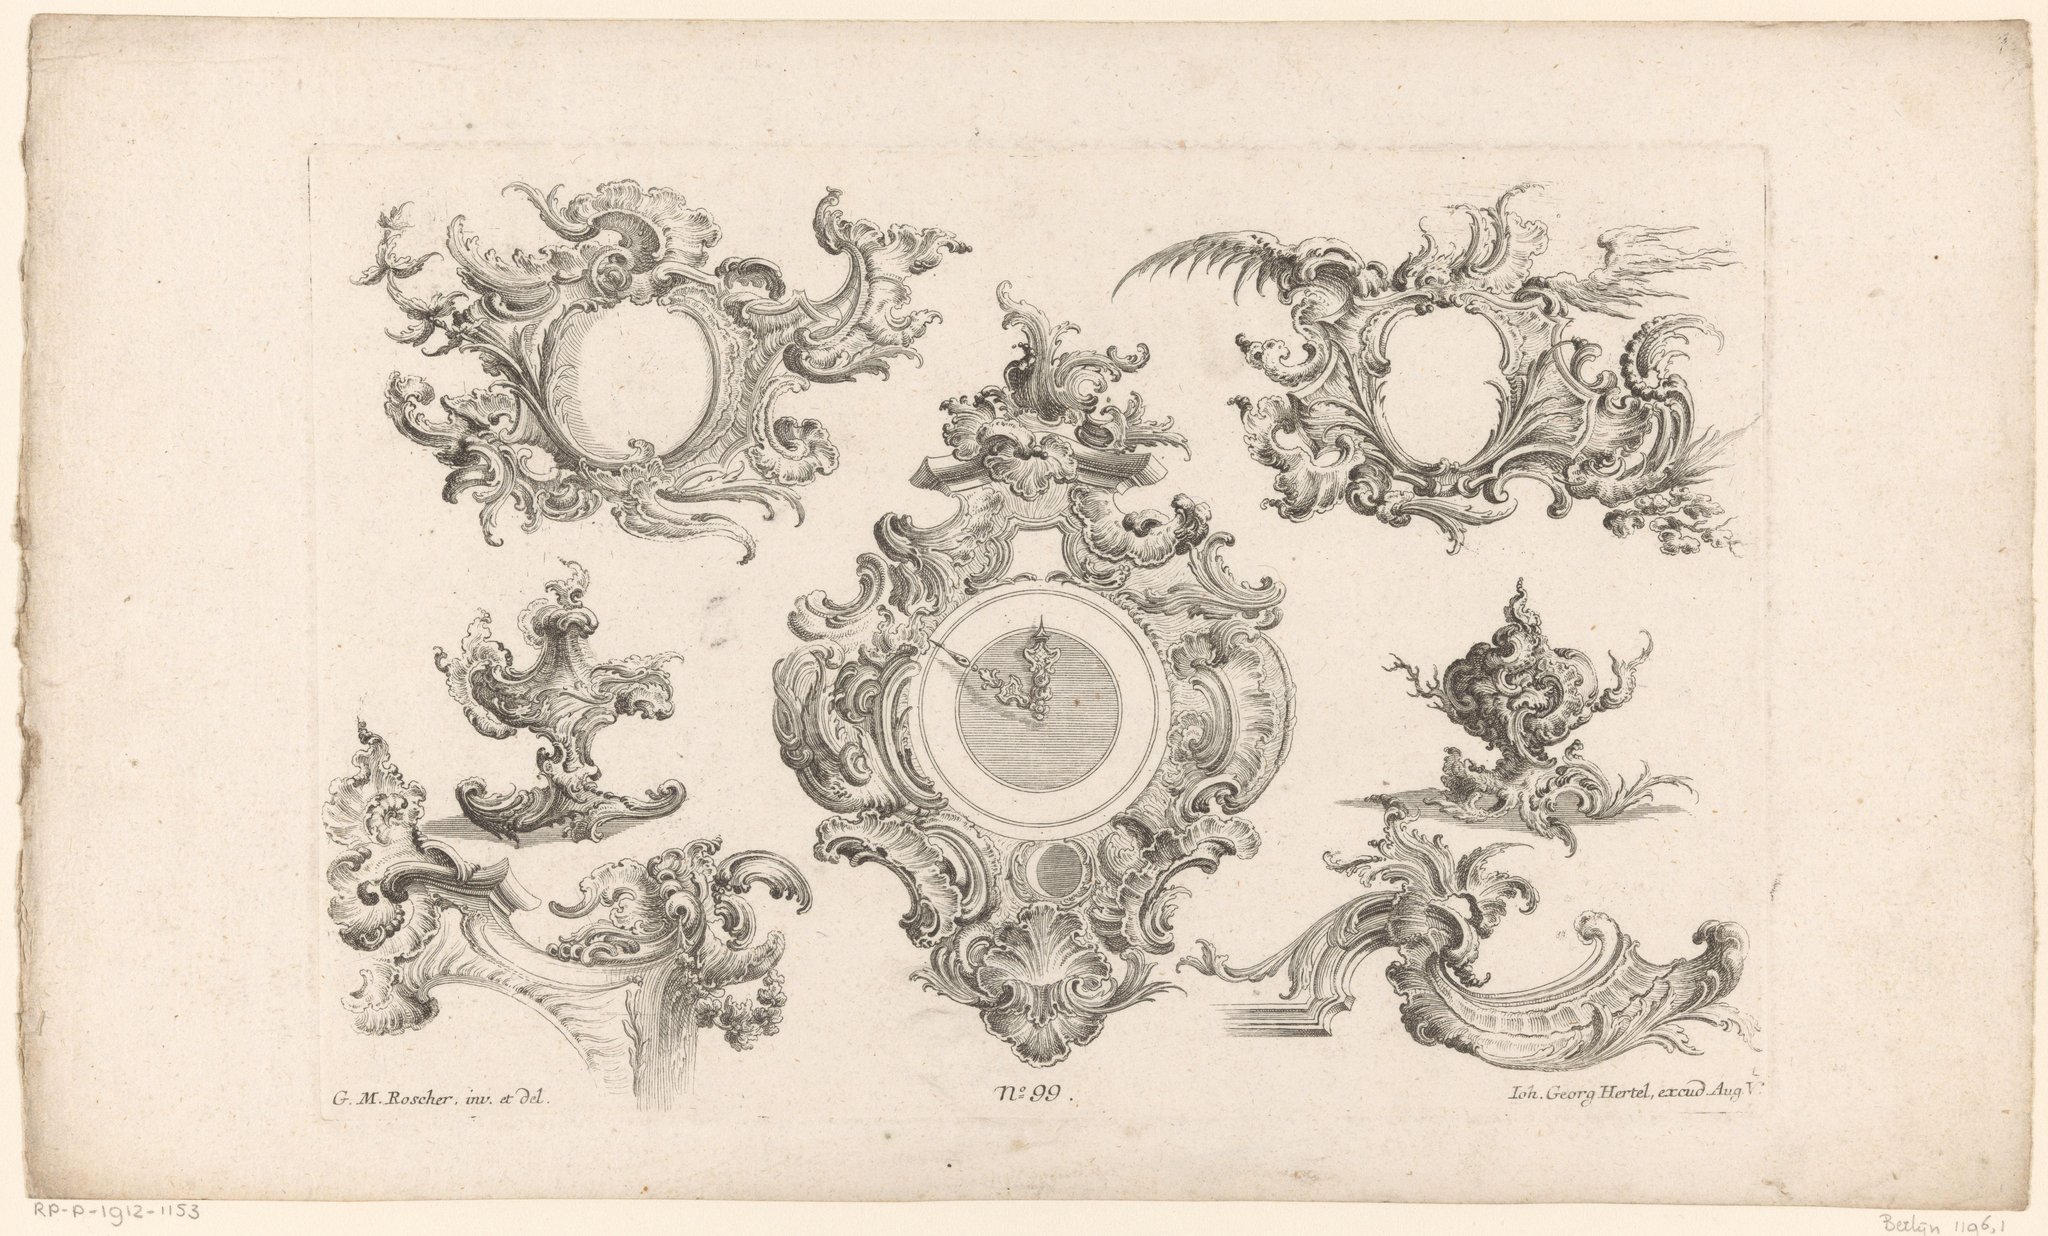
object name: print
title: Klokken en kleine meubels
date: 1705-1775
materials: paper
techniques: etching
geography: augsburg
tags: rocaille ornament, vase ~ ornament, clock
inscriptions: collector's mark: Lugt 2228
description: Rocaille ornamenten en cartouches en geornamenteerde klok en vazen. Uitgeversnummer 99.